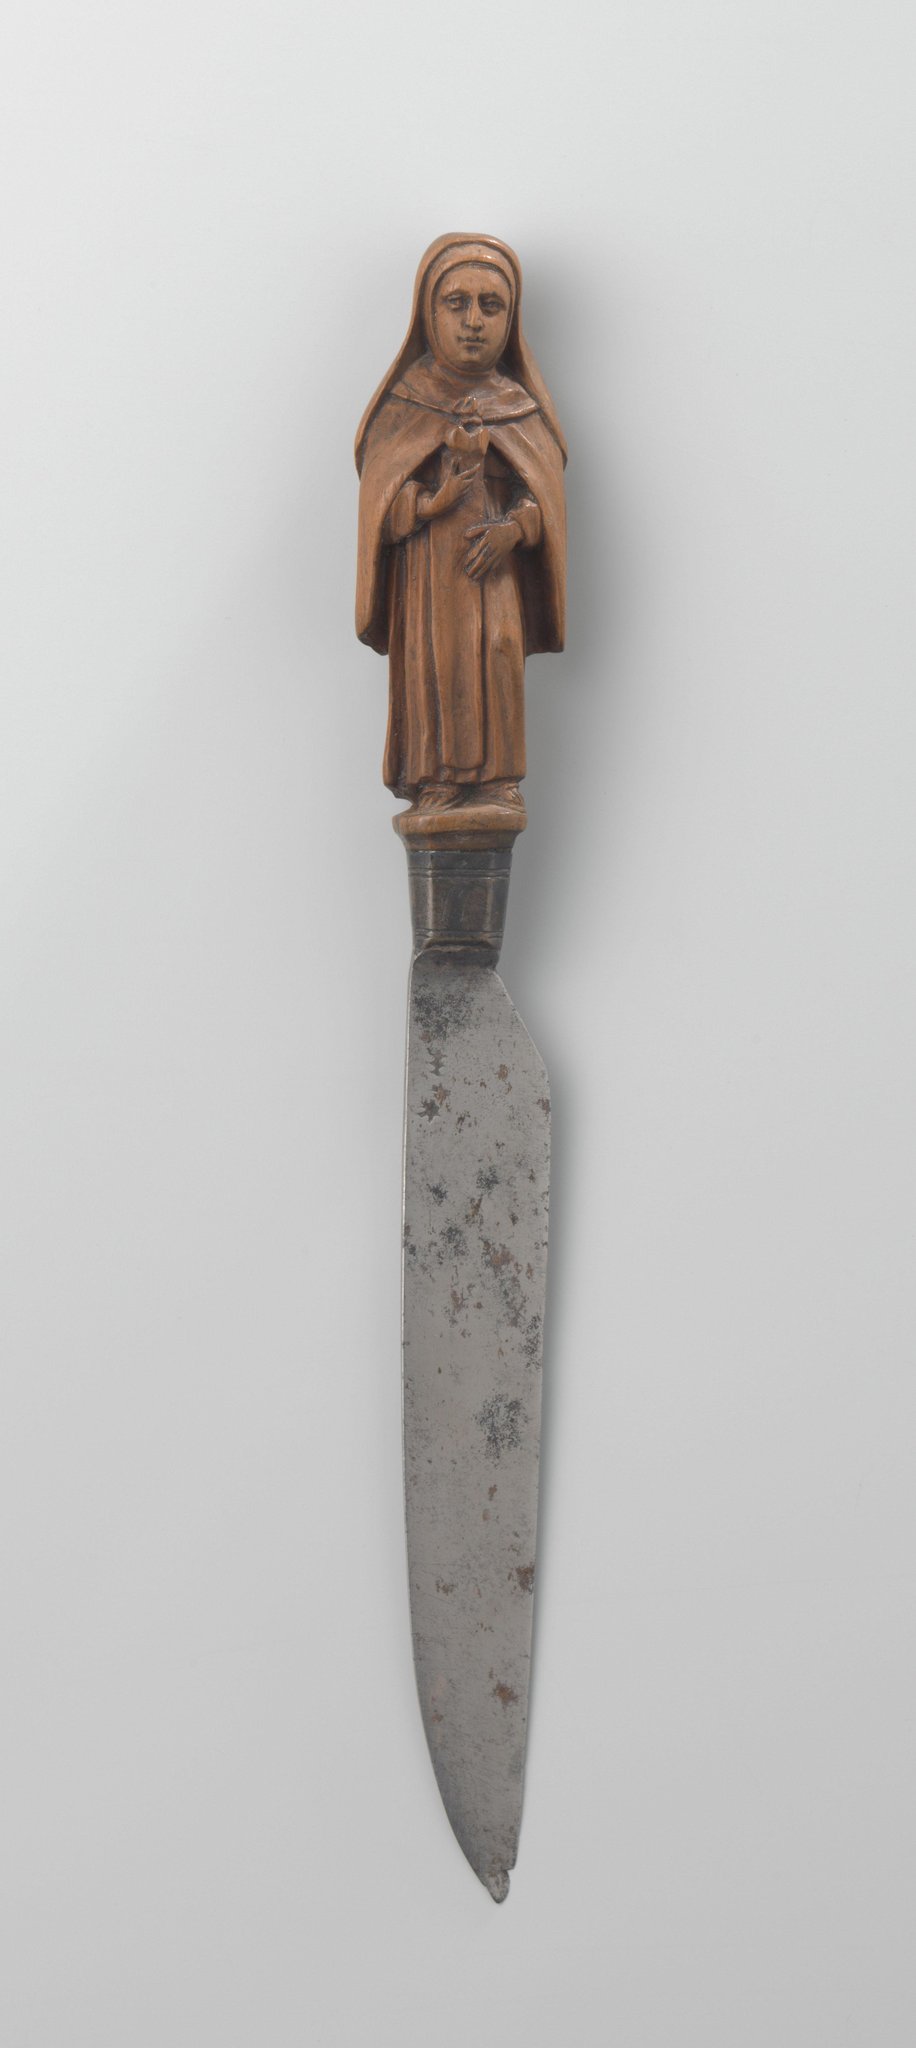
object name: knife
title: Knife with a Handle Representing a Nun with a Pot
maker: Anonymous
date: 1650-1700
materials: wood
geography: northern netherlands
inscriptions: number: ‘4’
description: De non houdt in haar rechter hand een vlammend hart.